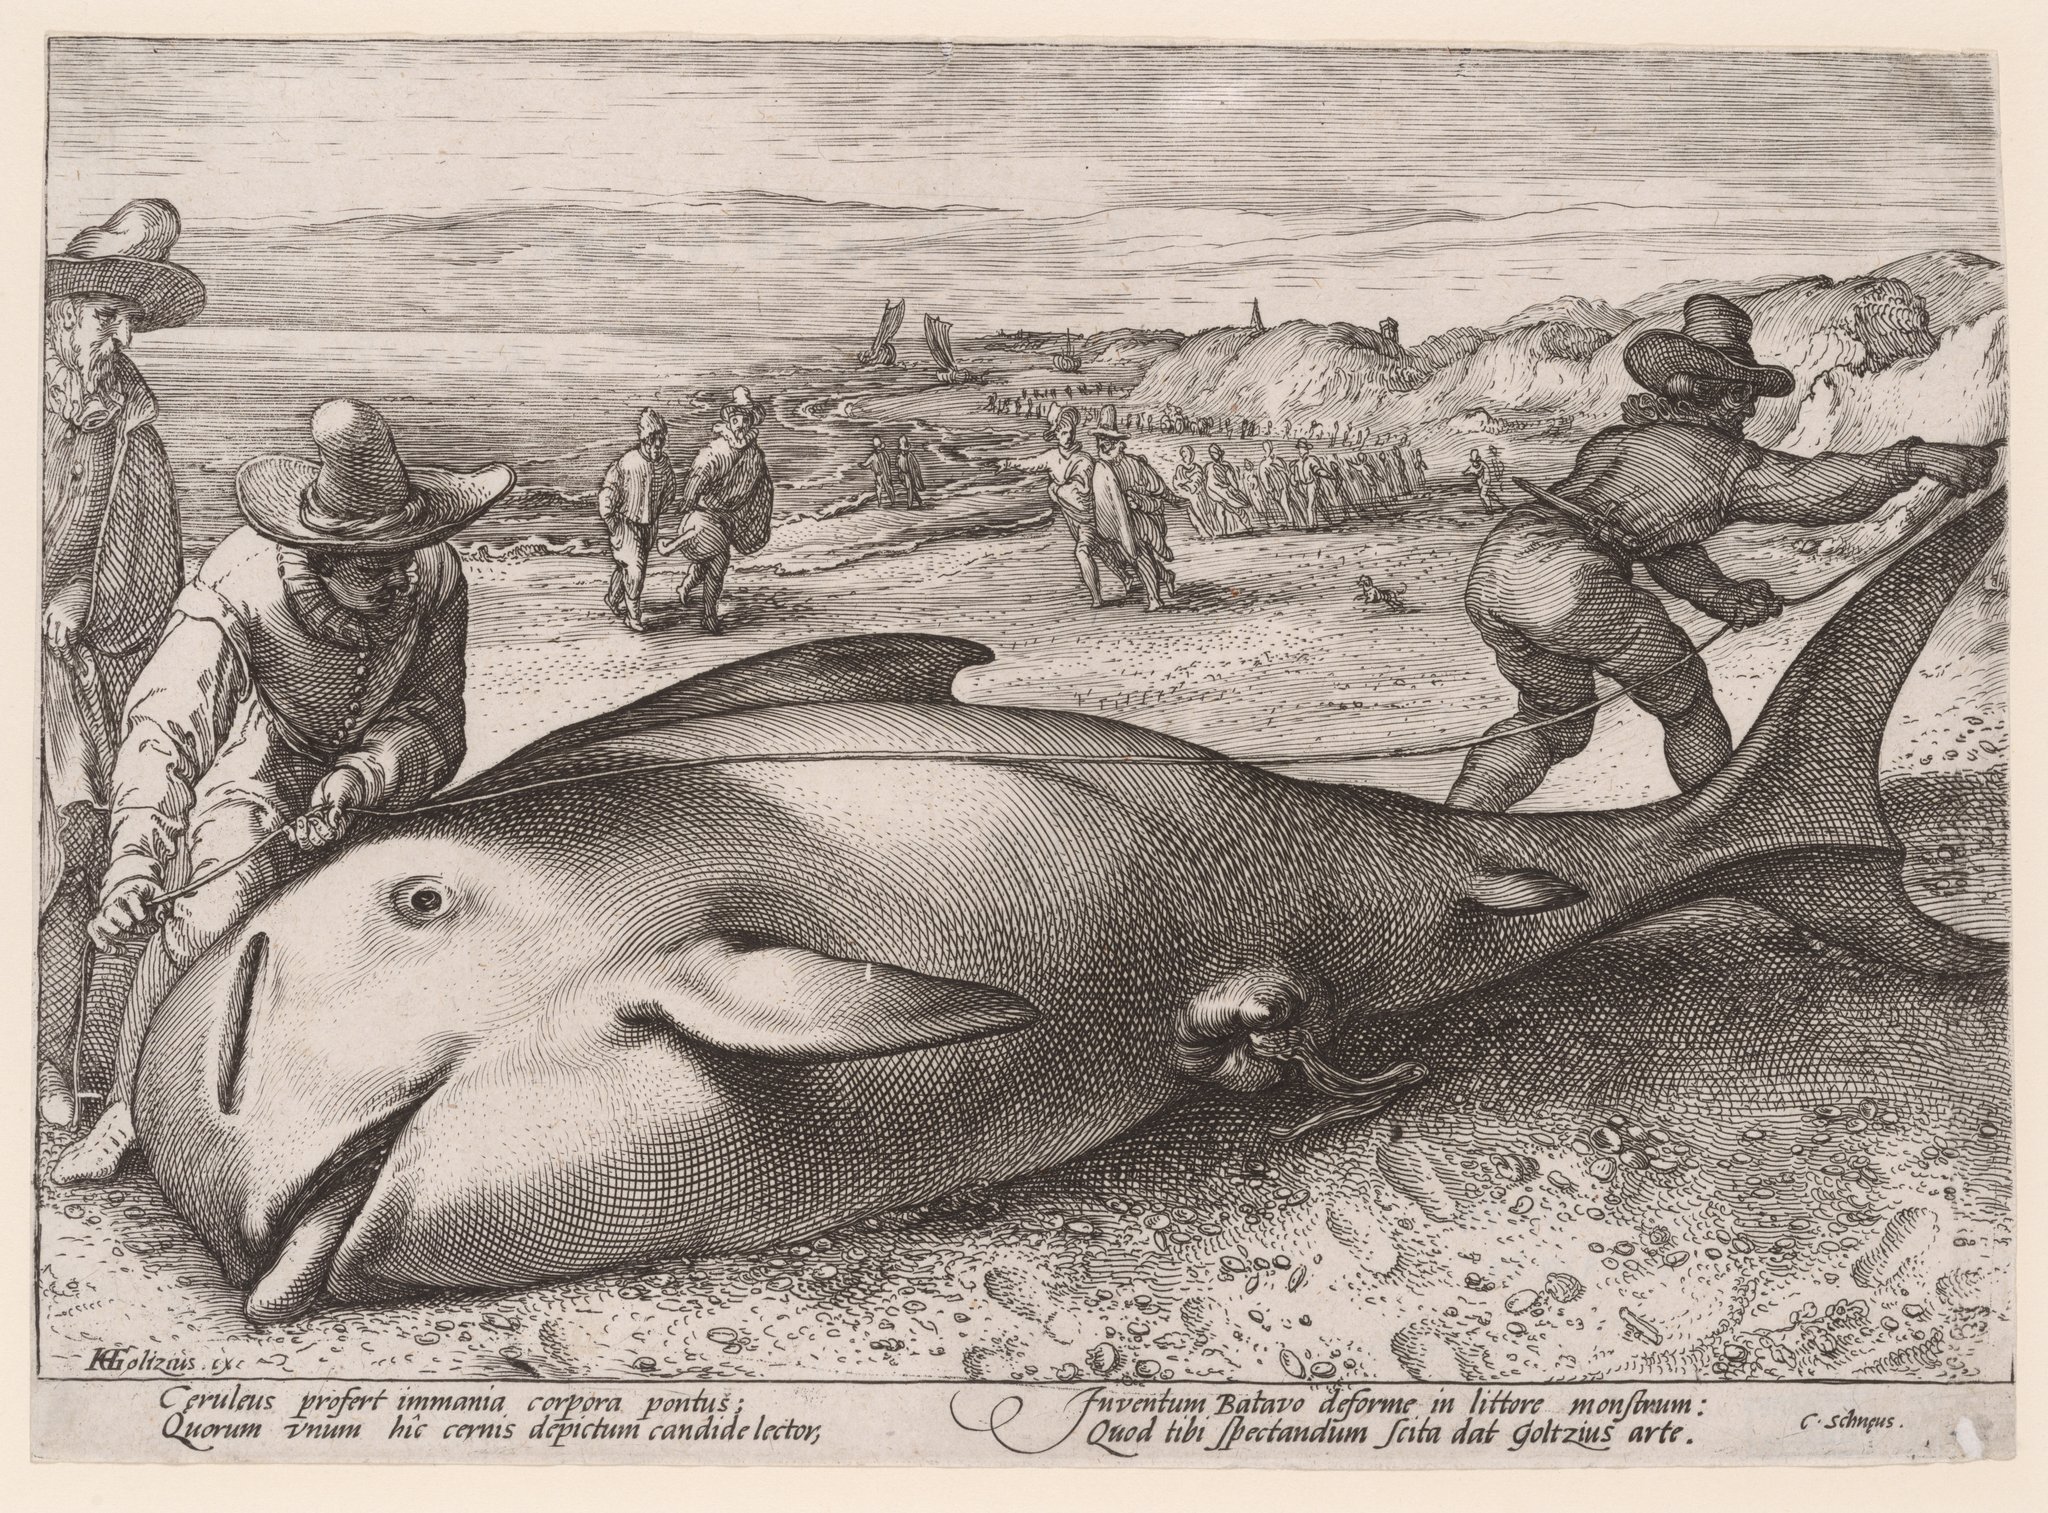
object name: print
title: A beached pilot whale near Zandvoort on 21 November, 1594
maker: hendrick goltzius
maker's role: artist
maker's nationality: netherlandish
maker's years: 1558-1617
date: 1594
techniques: engraving, etching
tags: whales